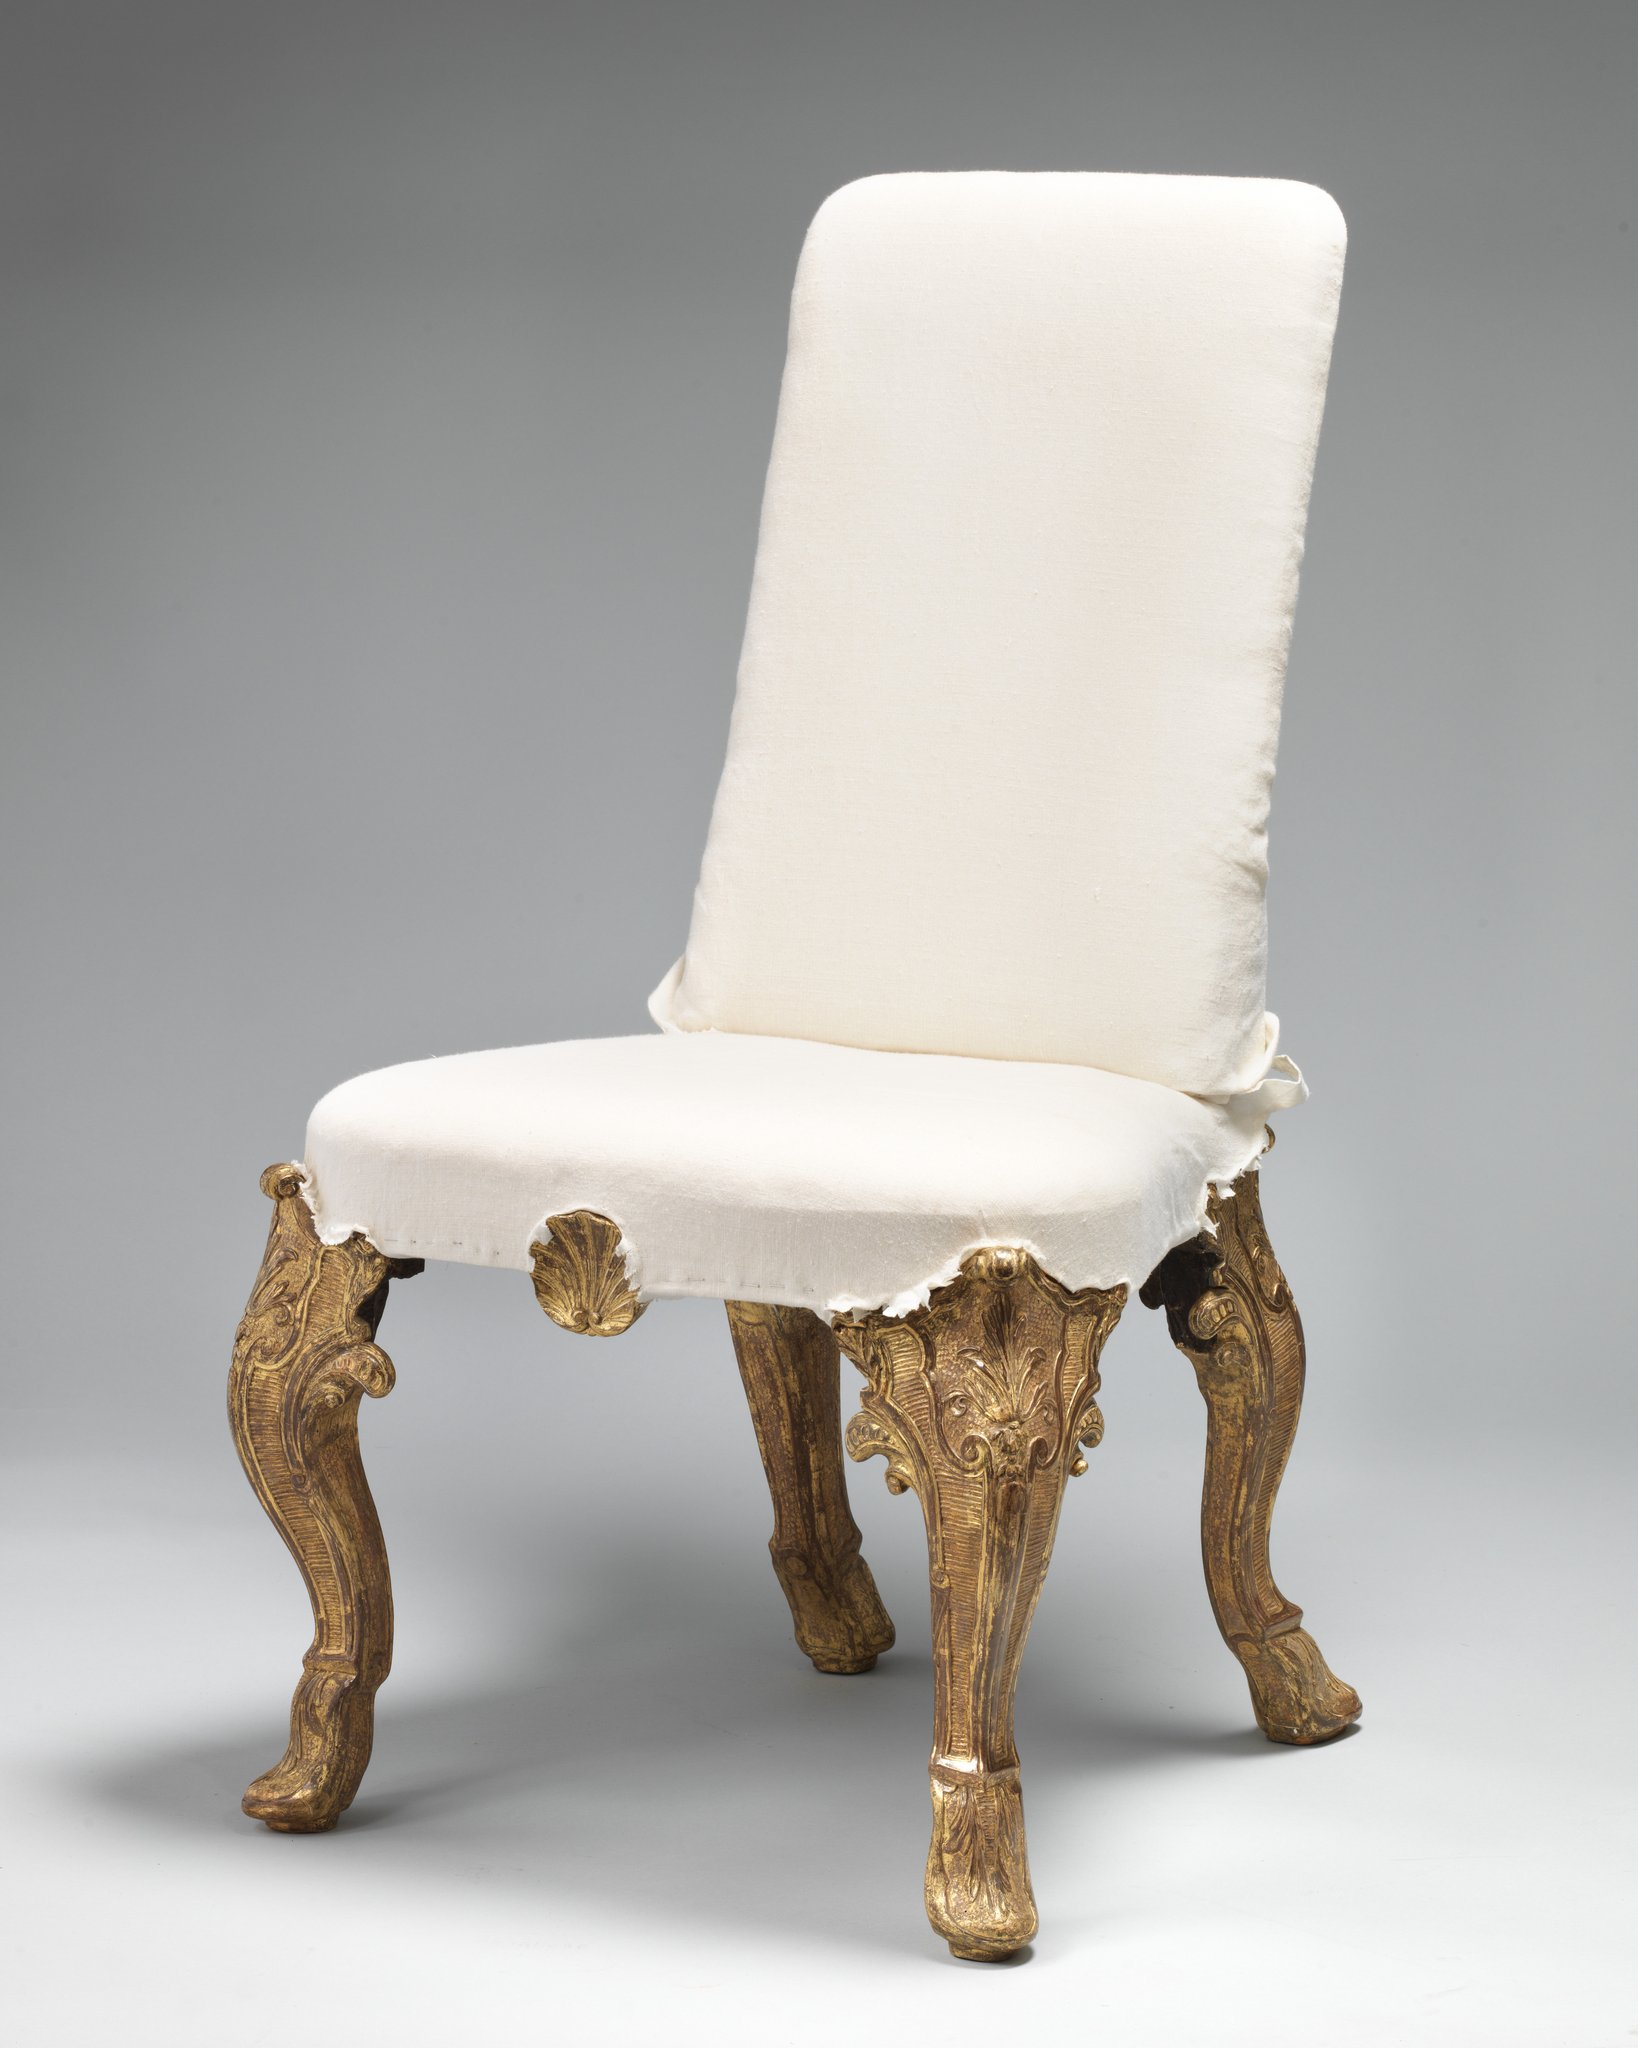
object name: side chair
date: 1710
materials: gesso, gilt, wood